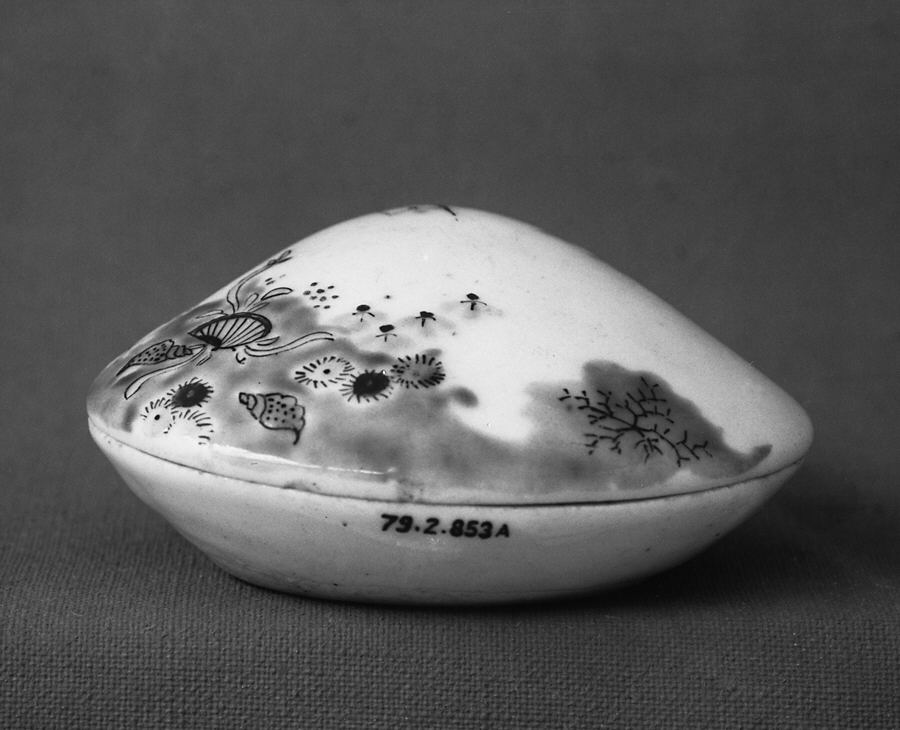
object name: covered dish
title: Covered Dish in Form of a Shell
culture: japanese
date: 1701-1800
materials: enamel, porcelain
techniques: overglaze, underglaze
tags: flowers,shells